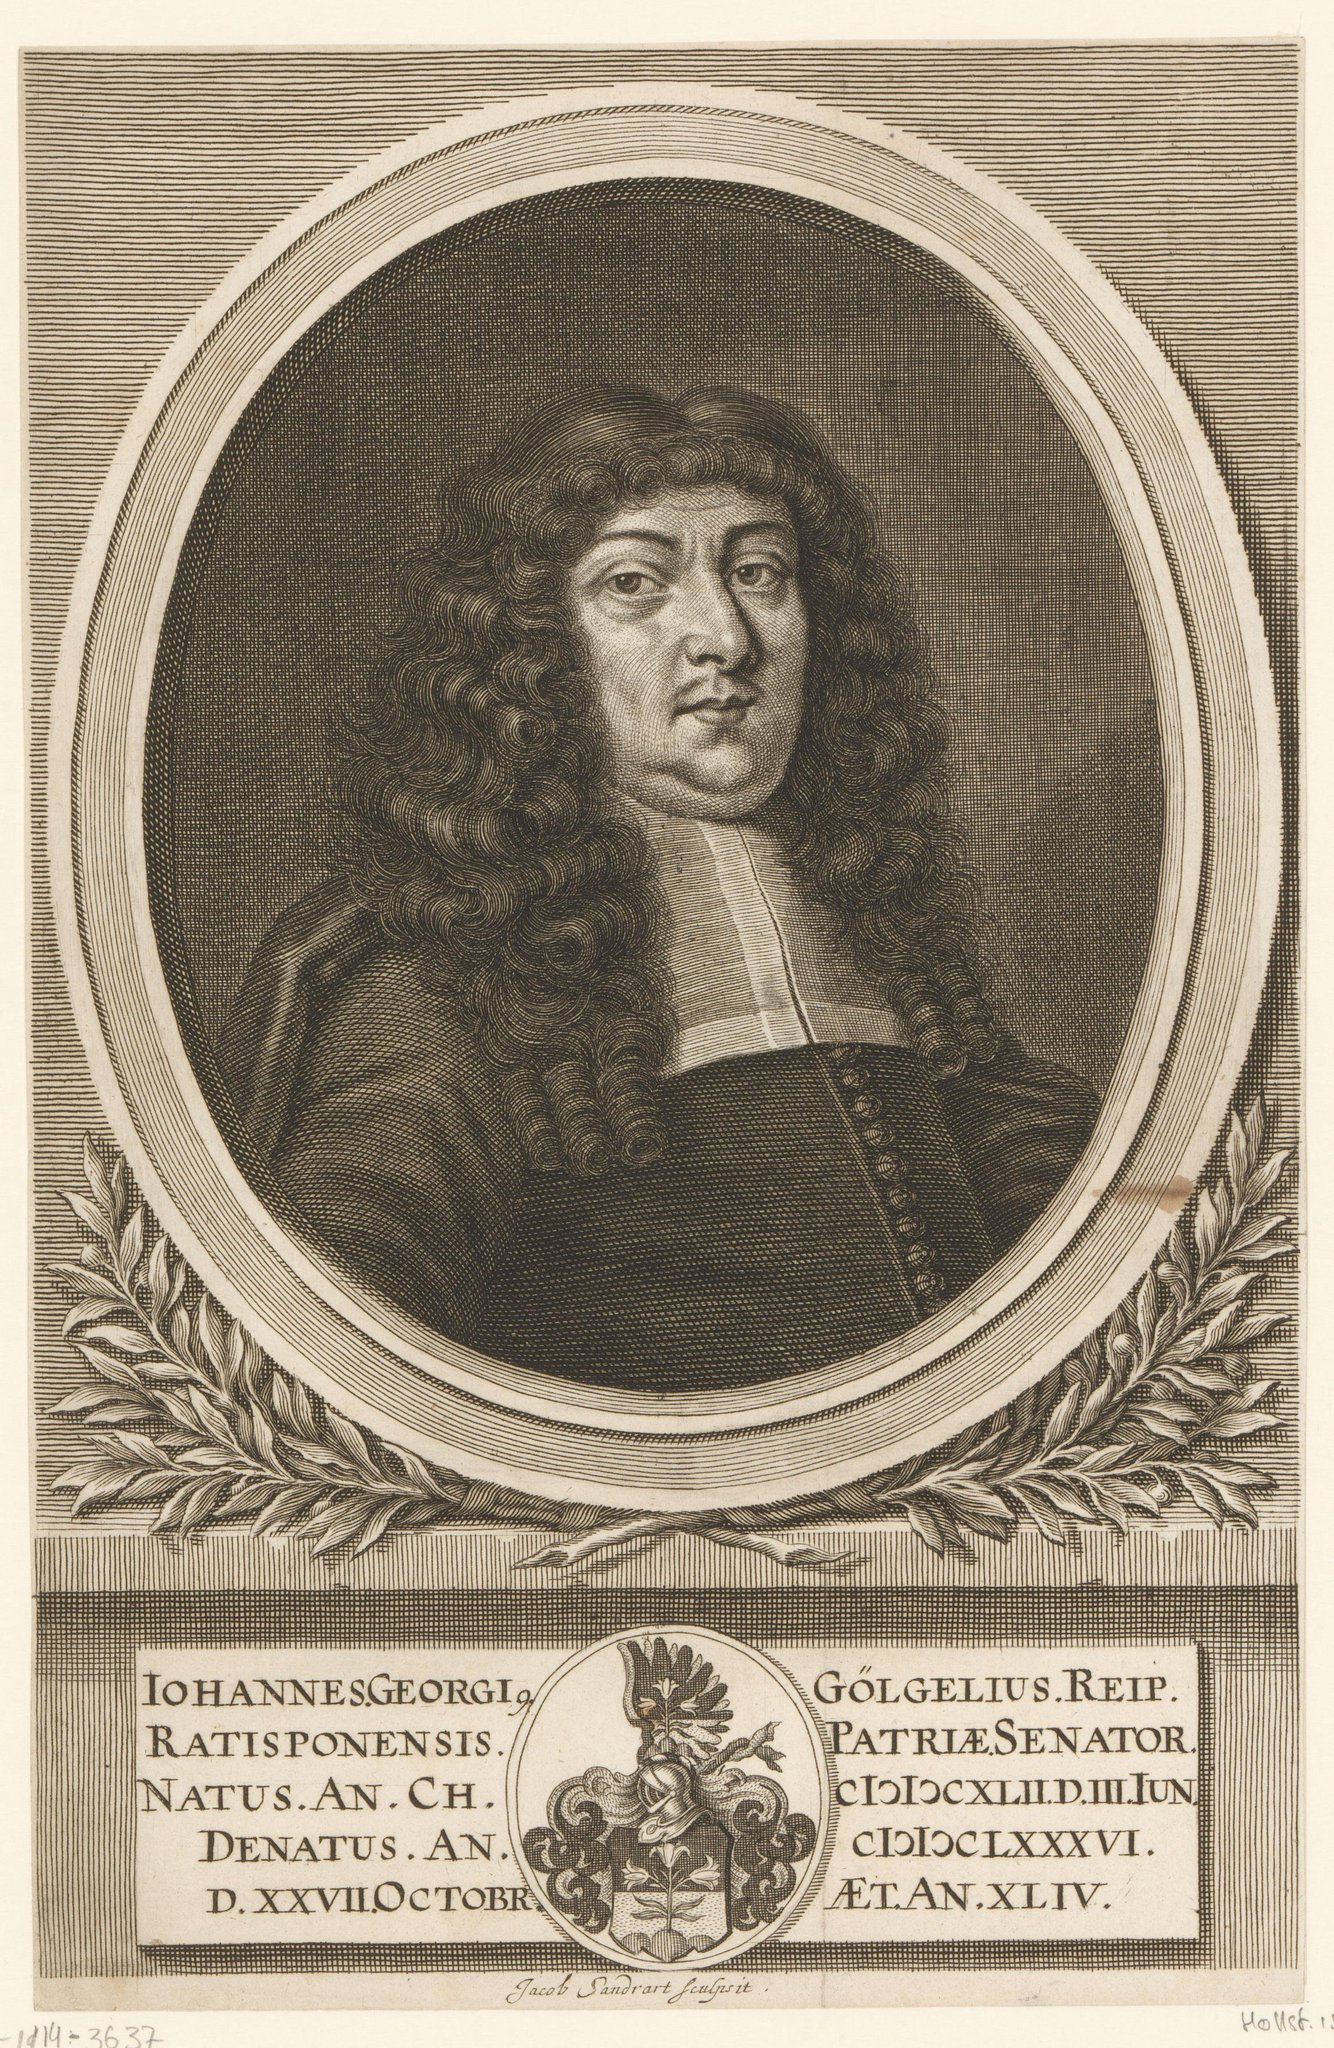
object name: print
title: Portret van Johann Georg Gölgel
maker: jakob von sandrart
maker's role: print maker, publisher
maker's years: 1630-1708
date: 1686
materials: paper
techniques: engraving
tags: historical persons, armorial bearing, heraldry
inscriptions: collector's mark: Lugt 2228